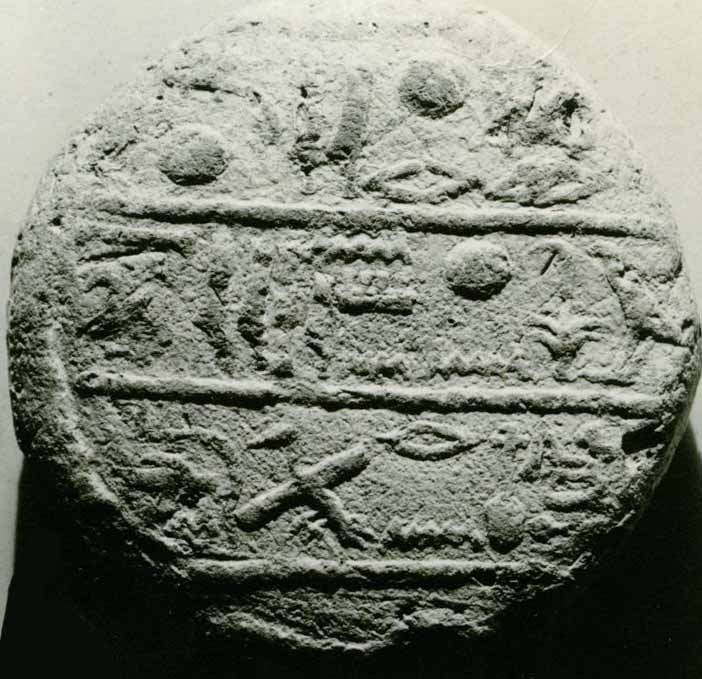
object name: cone, khonsu, parennefer, circular impression, branding iron, amun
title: Funerary Cone of Khonsu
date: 1550-1295 BCE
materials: pottery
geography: egypt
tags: hieroglyphs